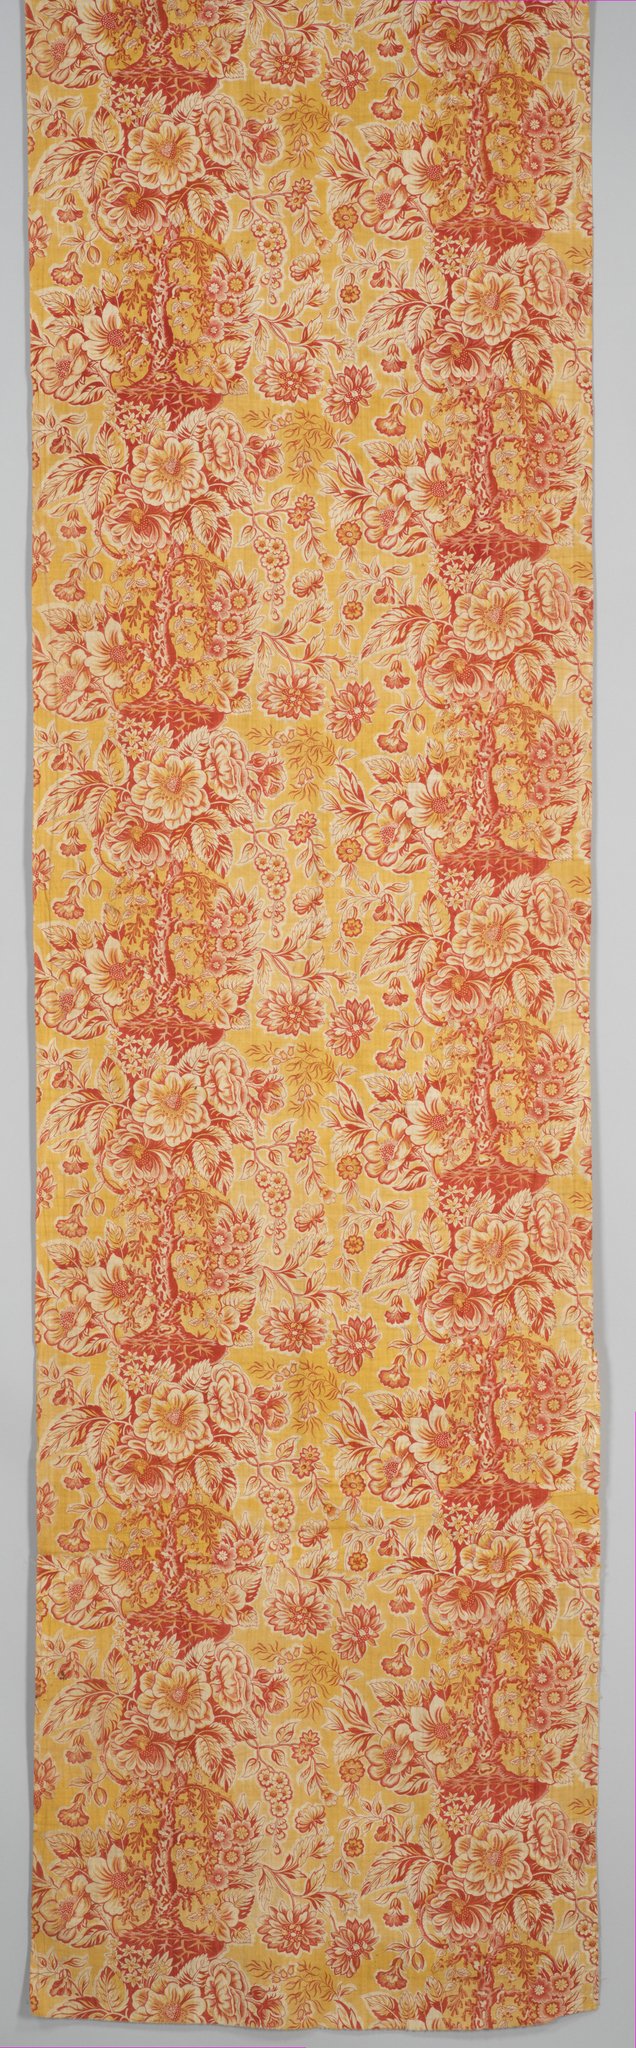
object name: length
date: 1820-1830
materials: cotton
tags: flowers